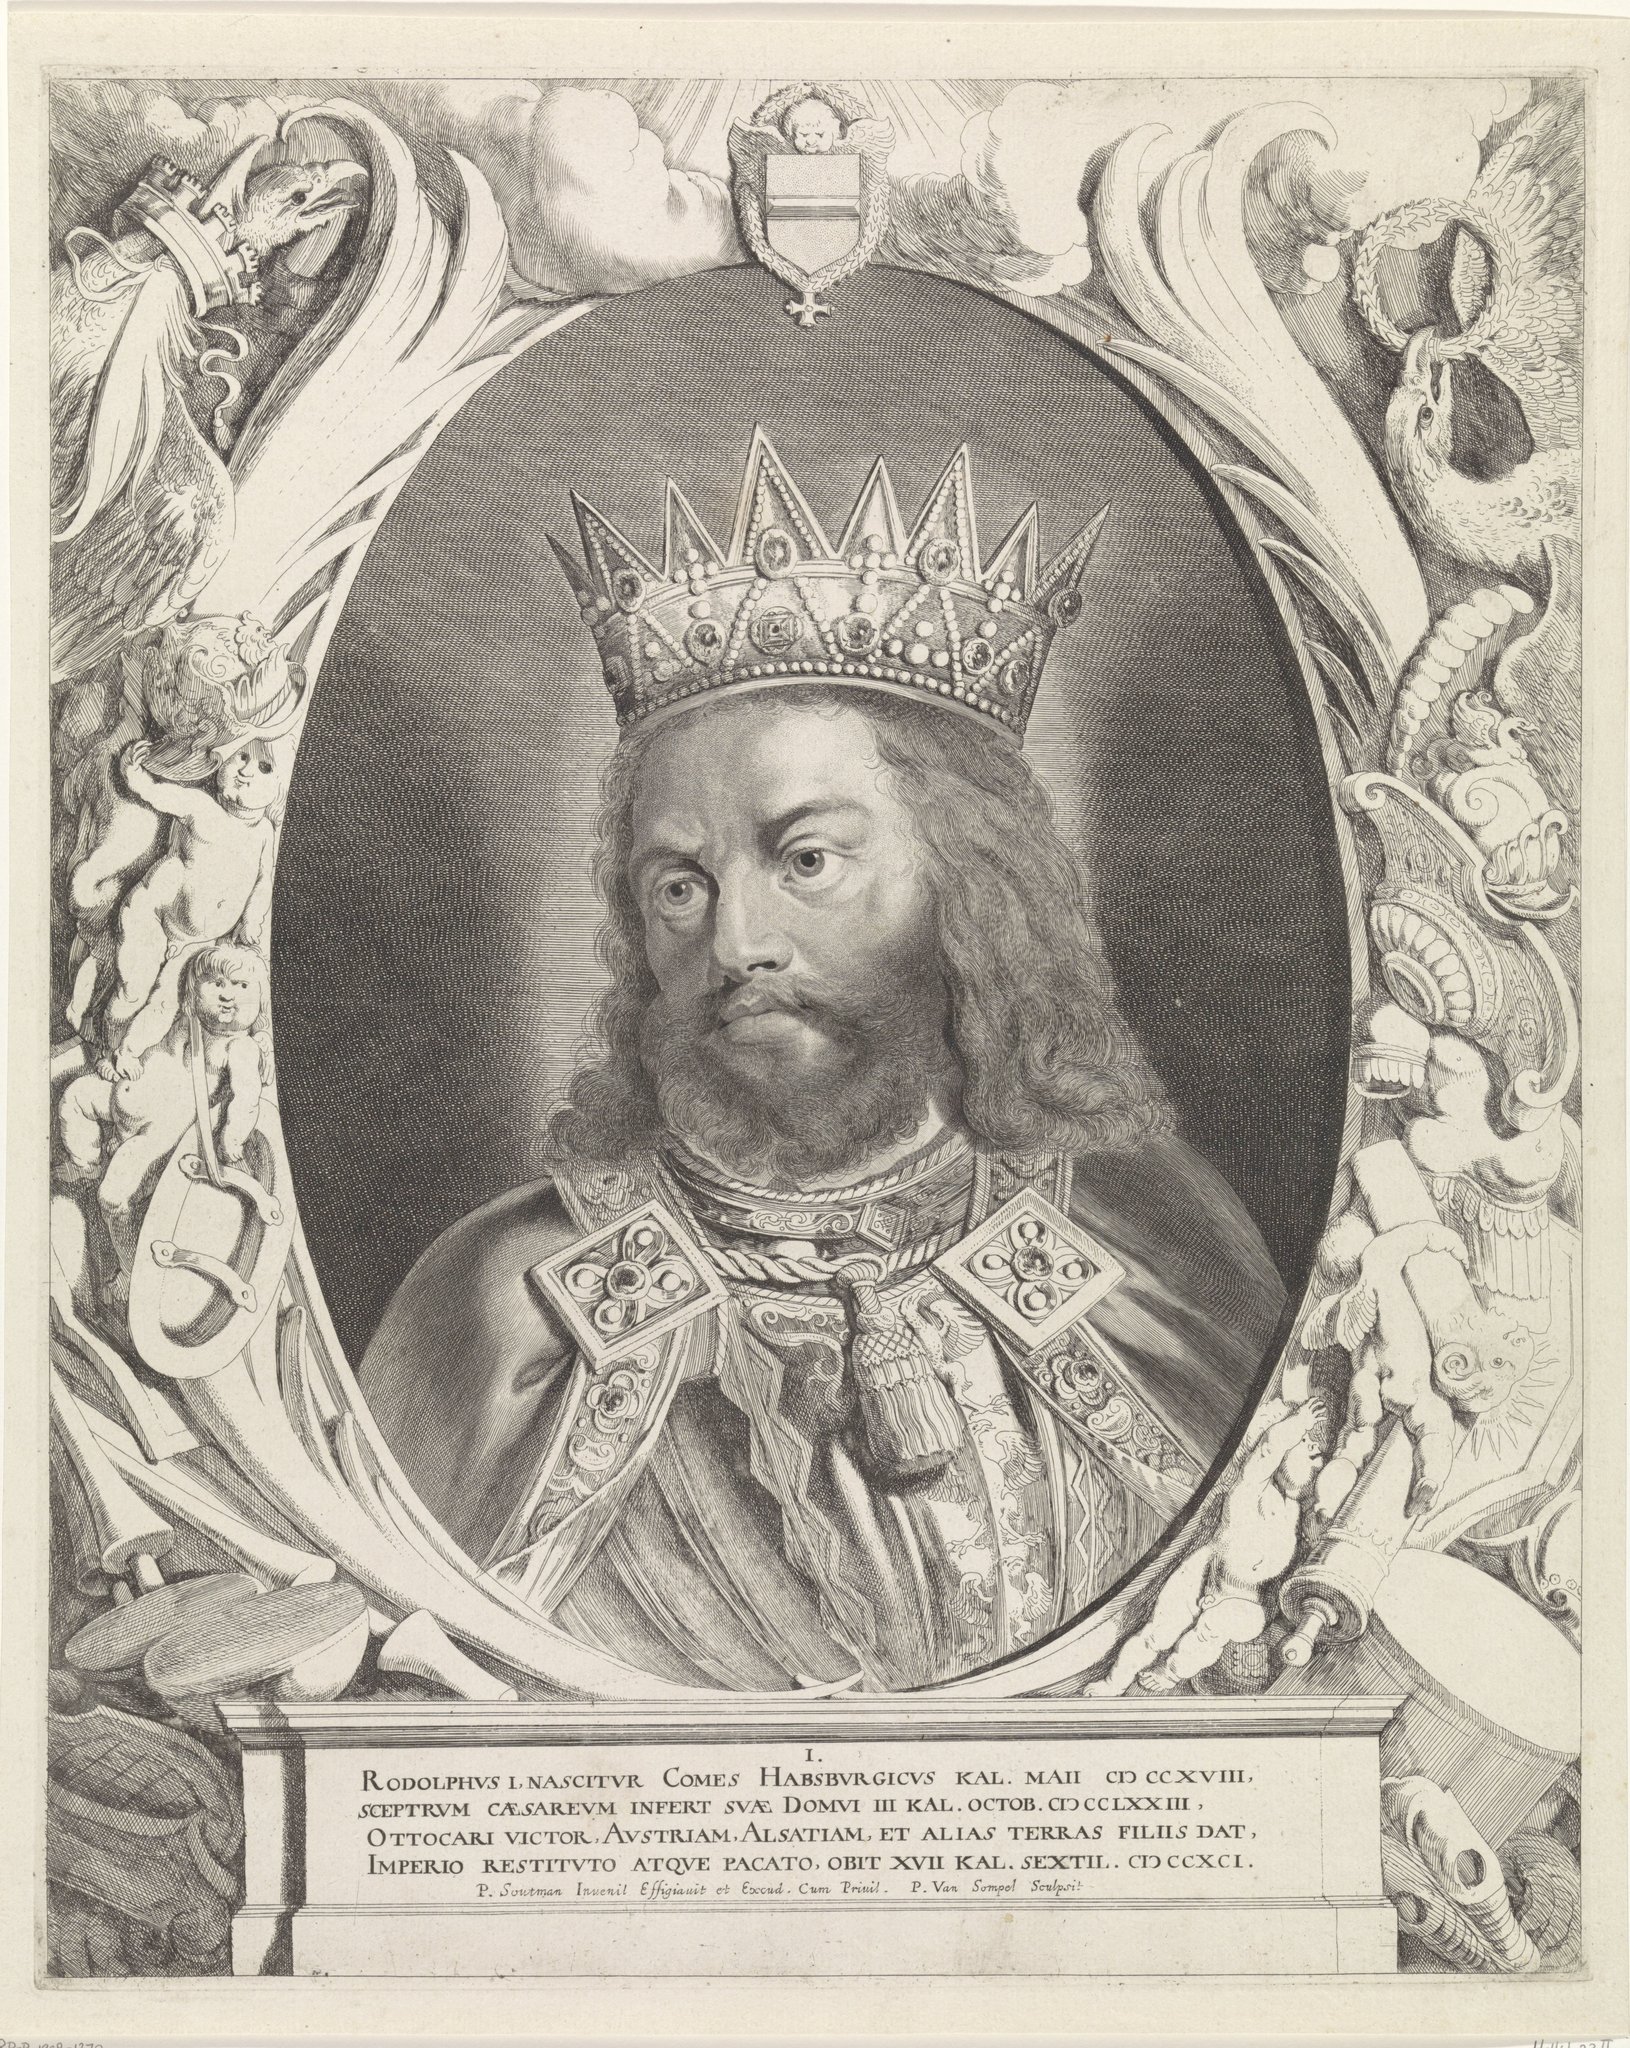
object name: print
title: Portret van Rudolf I van Habsburg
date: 1644-1650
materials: paper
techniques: engraving, etching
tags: crown (symbol of sovereignty)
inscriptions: collector's mark: Lugt 2228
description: Portret van Rudolf I van Habsburg (Duits keizer). Hij draagt een kroon op het hoofd. Het portret wordt omlijst door een randversiering met putti, wapens en harnasonderdelen. In de beide bovenhoeken een adelaar, in het midden zijn wapenschild. Onder het portret een voetstuk met daarop in het Latijn zijn naam, titels en een korte levensbeschrijving. Genummerd "I".